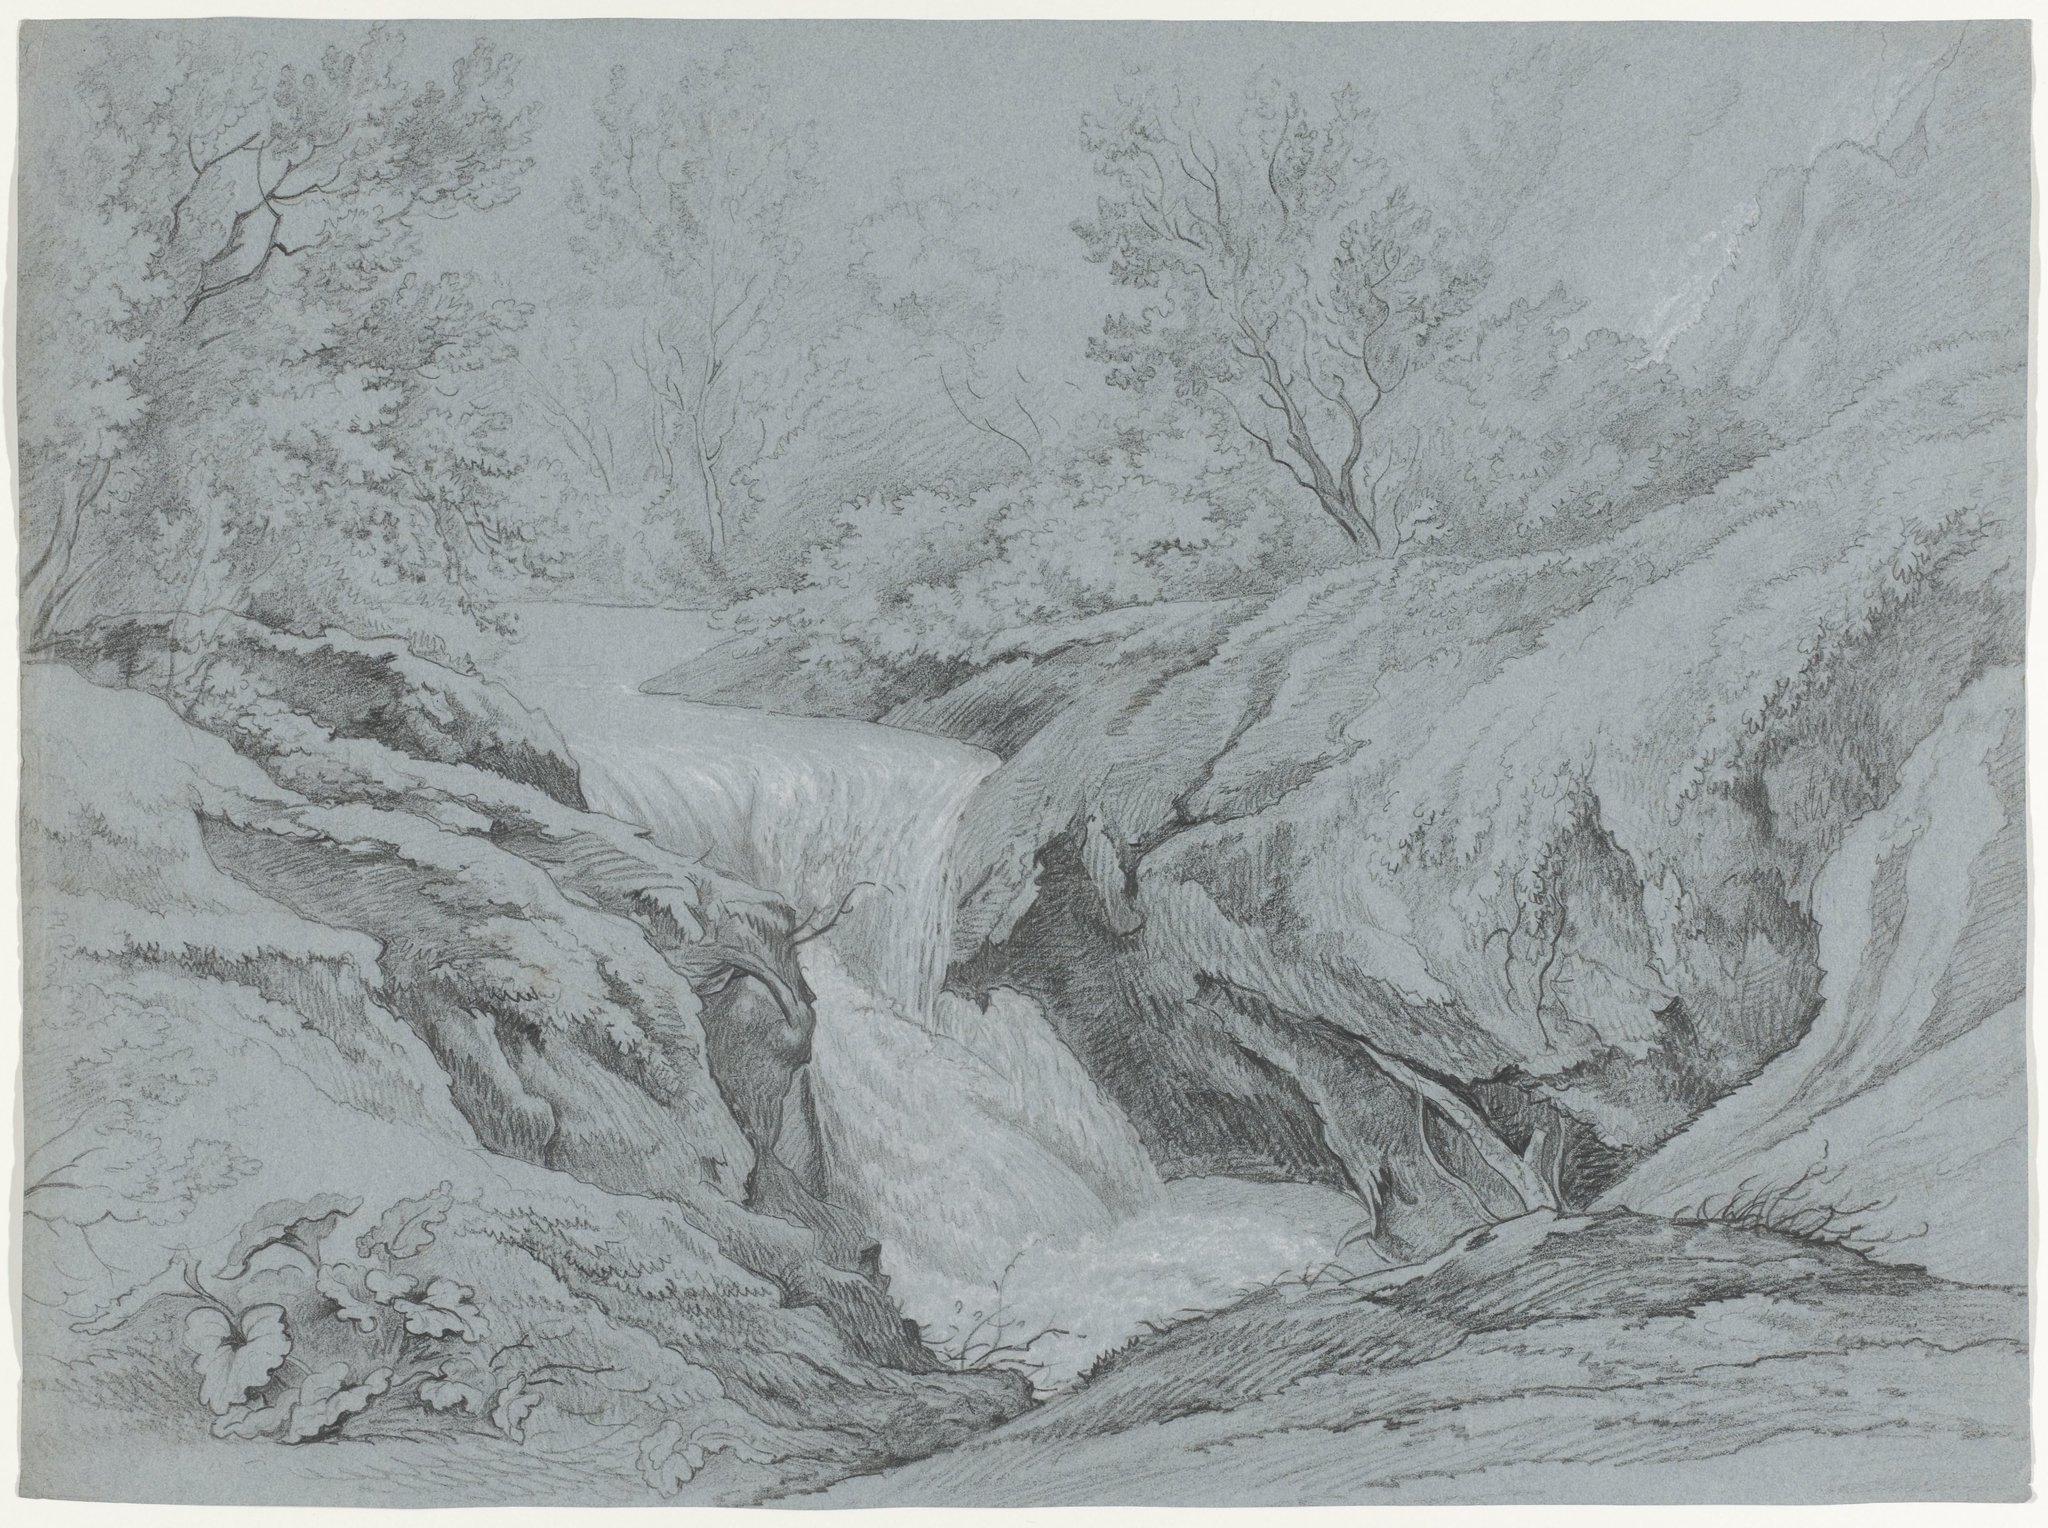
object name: drawing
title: Een waterval in de bergen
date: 1786-1857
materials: chalk, paper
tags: waterfall, mountains, italy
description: Tekening uit een groep tekeningen van landschappen en stadsgezichten in Italië (Rome, Tivoli, Civita Castellana en Pozzuoli).